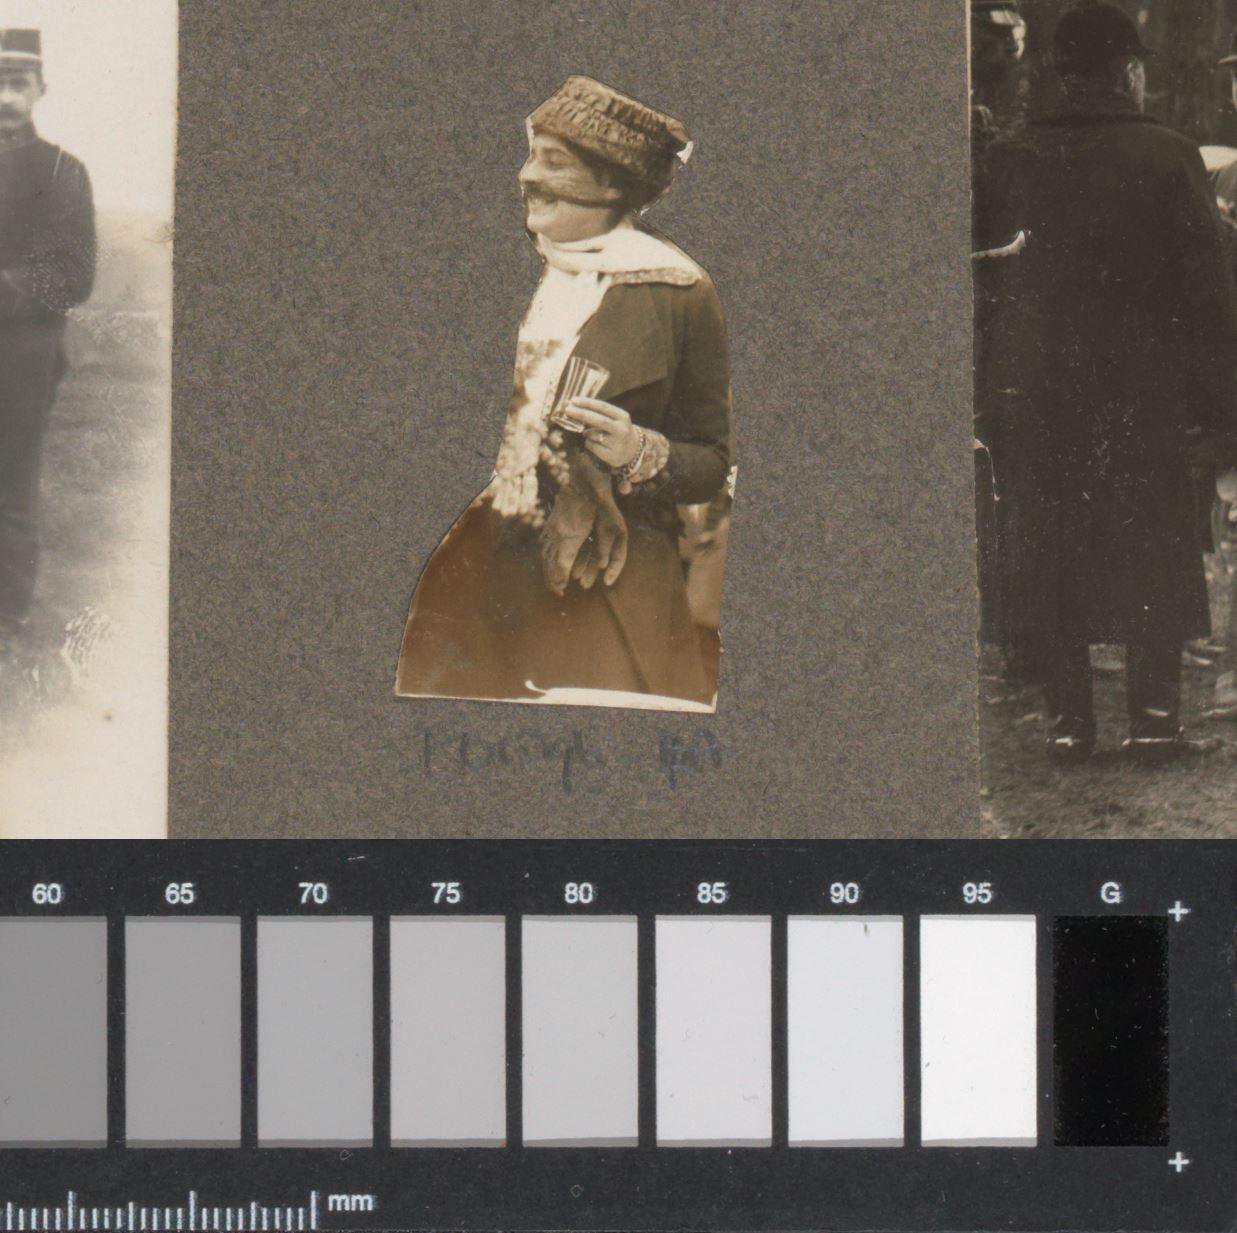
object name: album leaf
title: Ruitertafereel op Koninklijke Houtvesterij Het Loo: vrouw met glas in de hand (uitgeknipt)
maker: Anonymous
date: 1900-1925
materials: photographic support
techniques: gelatin silver print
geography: het loo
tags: adult woman, hunting, chase, hunting-ground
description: Onderdeel van Fotoalbum van de heer Brams, opperhoutvester van koningin Wilhelmina op Koninklijke Houtvesterij Het Loo.